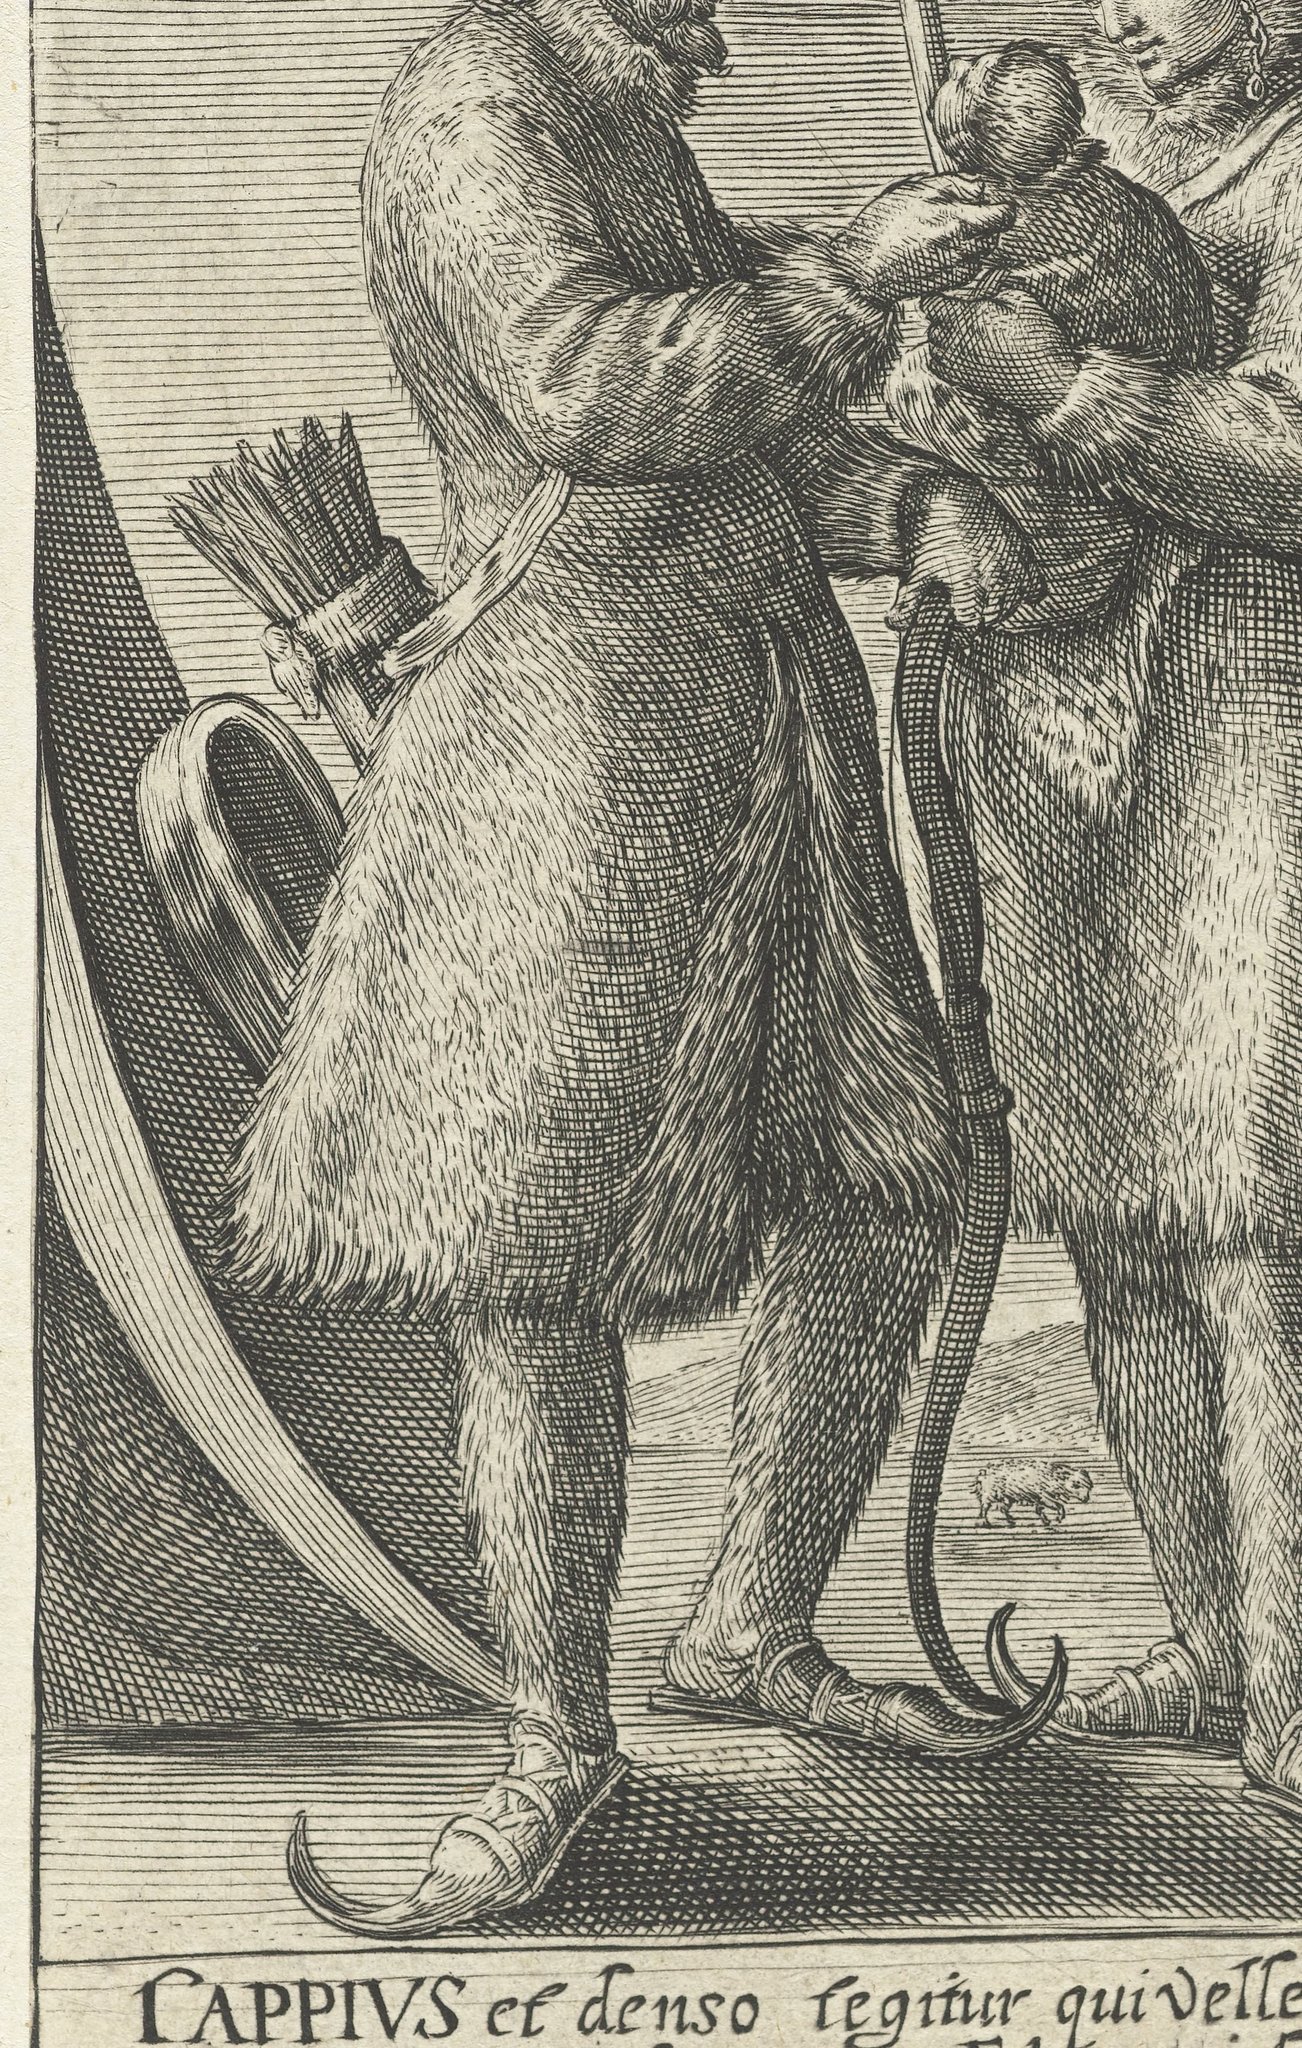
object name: costume print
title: Februari: een paar uit Lapland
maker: crispijn van de passe (ii)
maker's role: draughtsman, print maker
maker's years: 1594-1670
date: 1604-1670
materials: paper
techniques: engraving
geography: northern netherlands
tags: baby-carriage, pram, perambulator, europeans: sami, coat (+ fur used for clothes), coat (+ women's clothes), coat (+ men's clothes), pisces (zodiacal sign of february), head-gear: hat (+ men's clothes), head-gear: cap (+ women's clothes), clothes, costume (+ women's clothes), clothes, costume (+ men's clothes), february ~ other concepts, sápmi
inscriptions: caption: ‘LAPPIVS et denso tegitur qui vellere vulpis / ISLANDVS glaecem et Februari frigira [frigora] vincunt.’, inscription: ‘110’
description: Man en vrouw uit Sápmi (Lapland), gekleed in kostuums van bont, bontmutsen op het hoofd. De vrouw draagt een baby in haar armen en een houten korf op haar rug. Boven hen het teken van Vissen. In de marge een tweeregelig onderschrift in het Latijn dat vermeldt dat De LAP en de IJSLANDER die zich hullen in een dik vossevel, de kou van februari overwinnen. Prent uit een serie met de twaalf maanden weergegeven door tekens van de dierenriem en paren die kleding uit verschillende landen dragen.